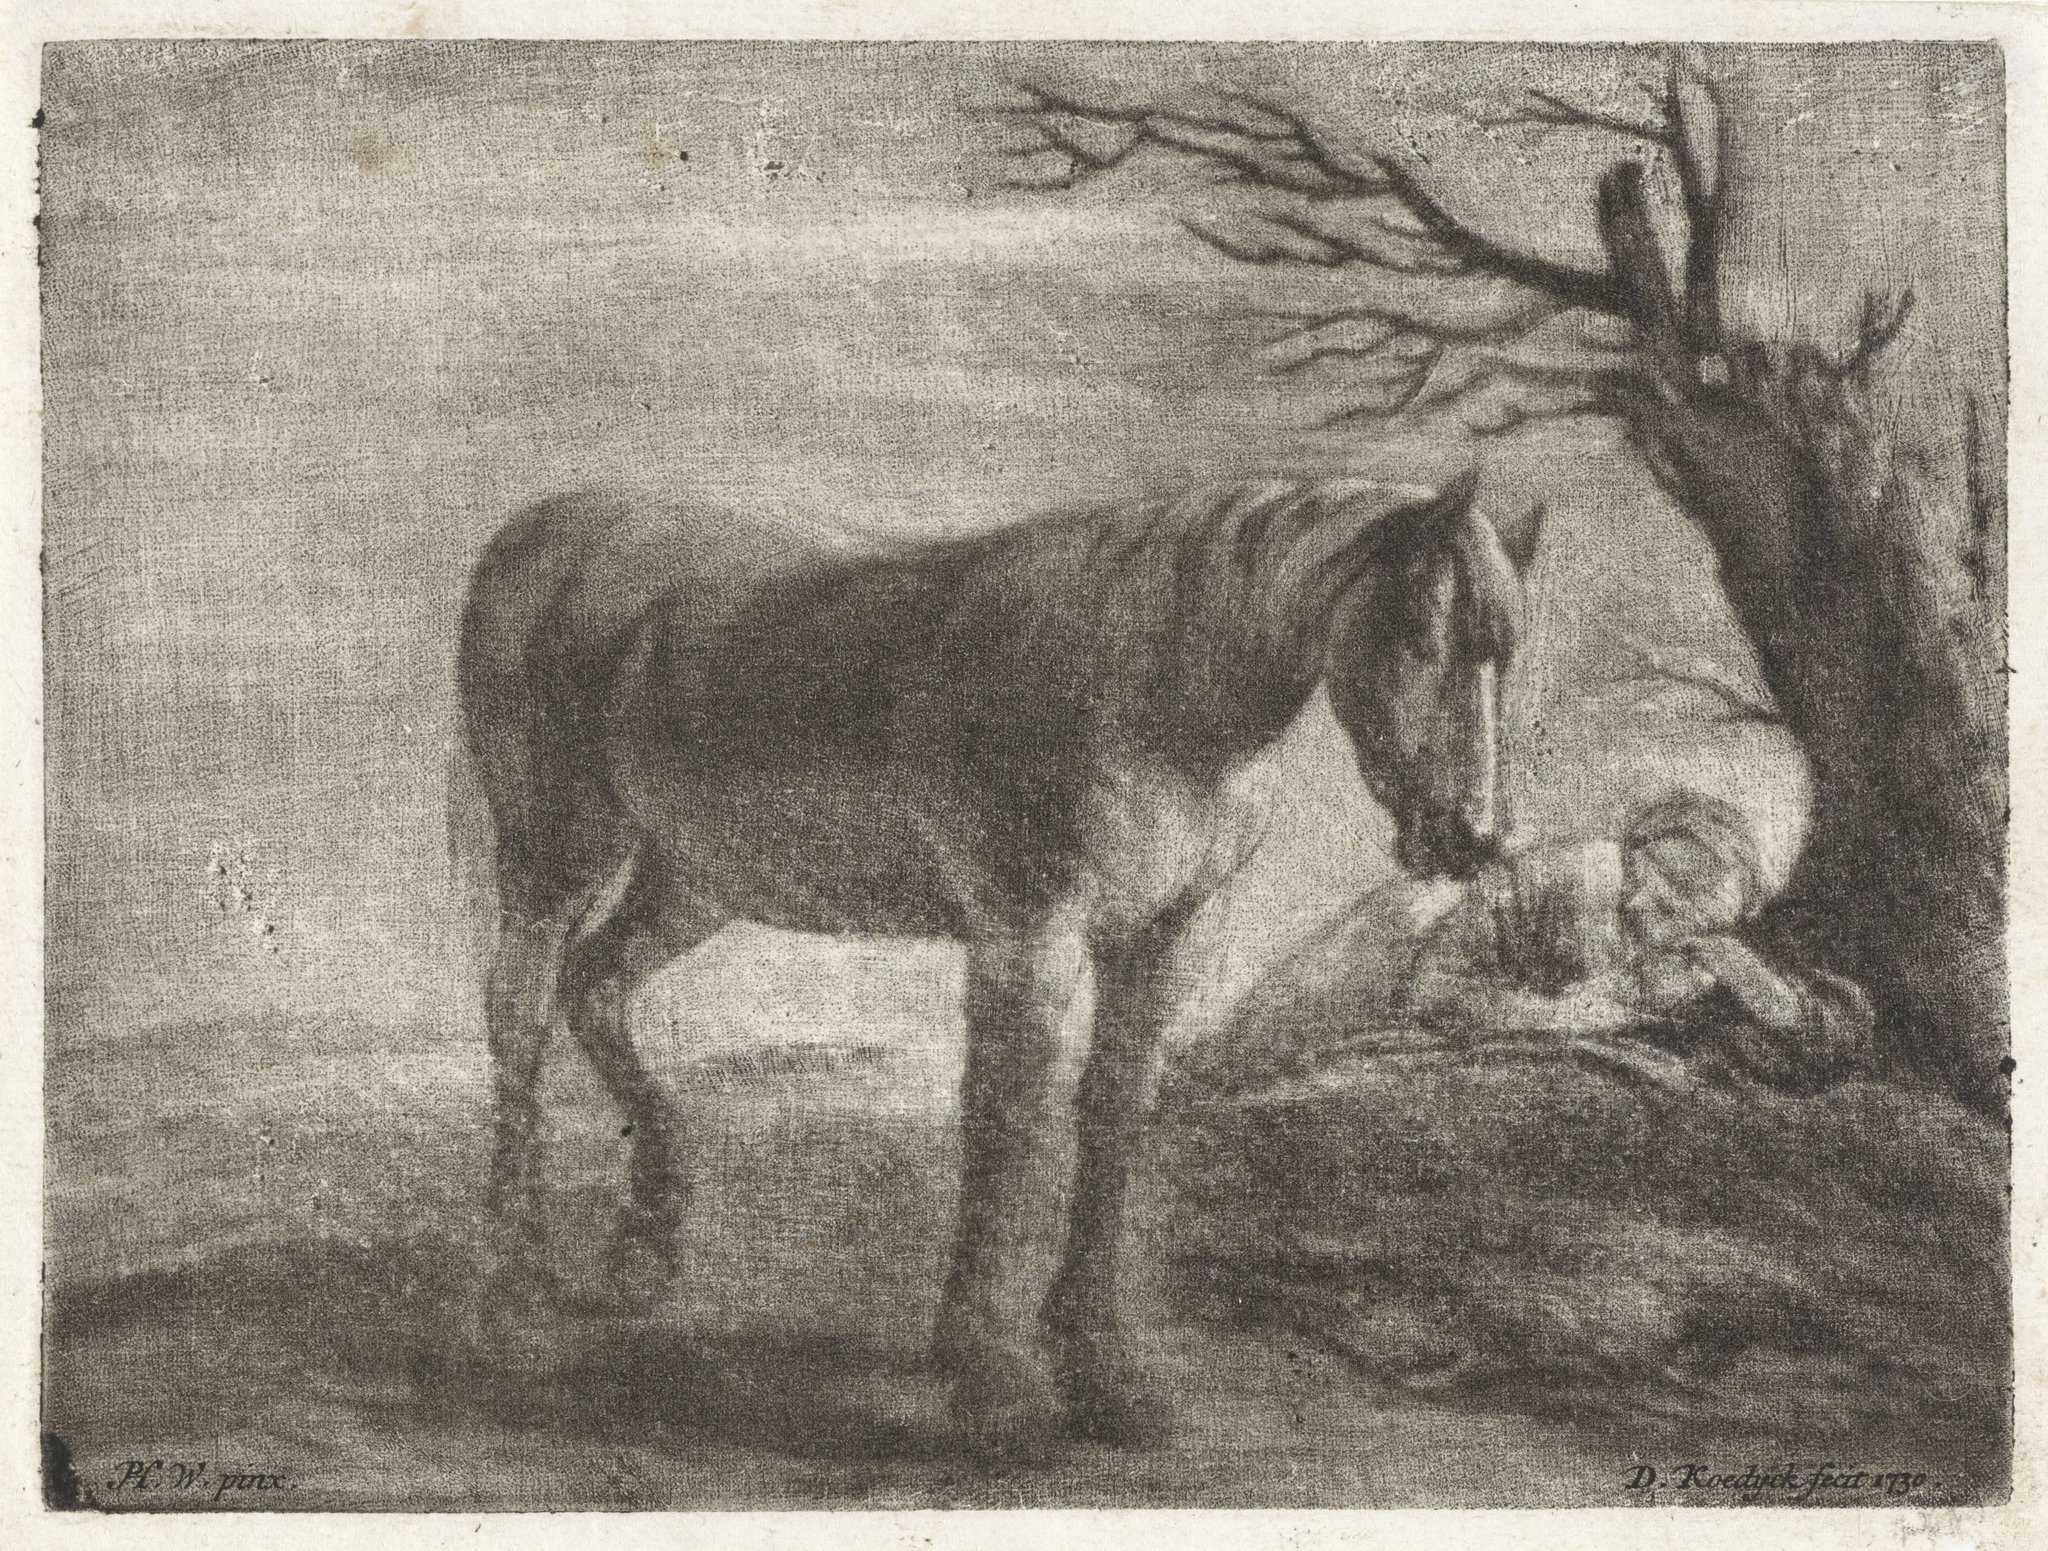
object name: print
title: Lanschap met een paard en een slapende vrouw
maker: dirk koedijck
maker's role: print maker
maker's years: 1681-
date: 1730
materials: paper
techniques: engraving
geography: zaandam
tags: horses and kindred animals, landscapes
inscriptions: collector's mark: Lugt 2228, collector's mark: Lugt 2760